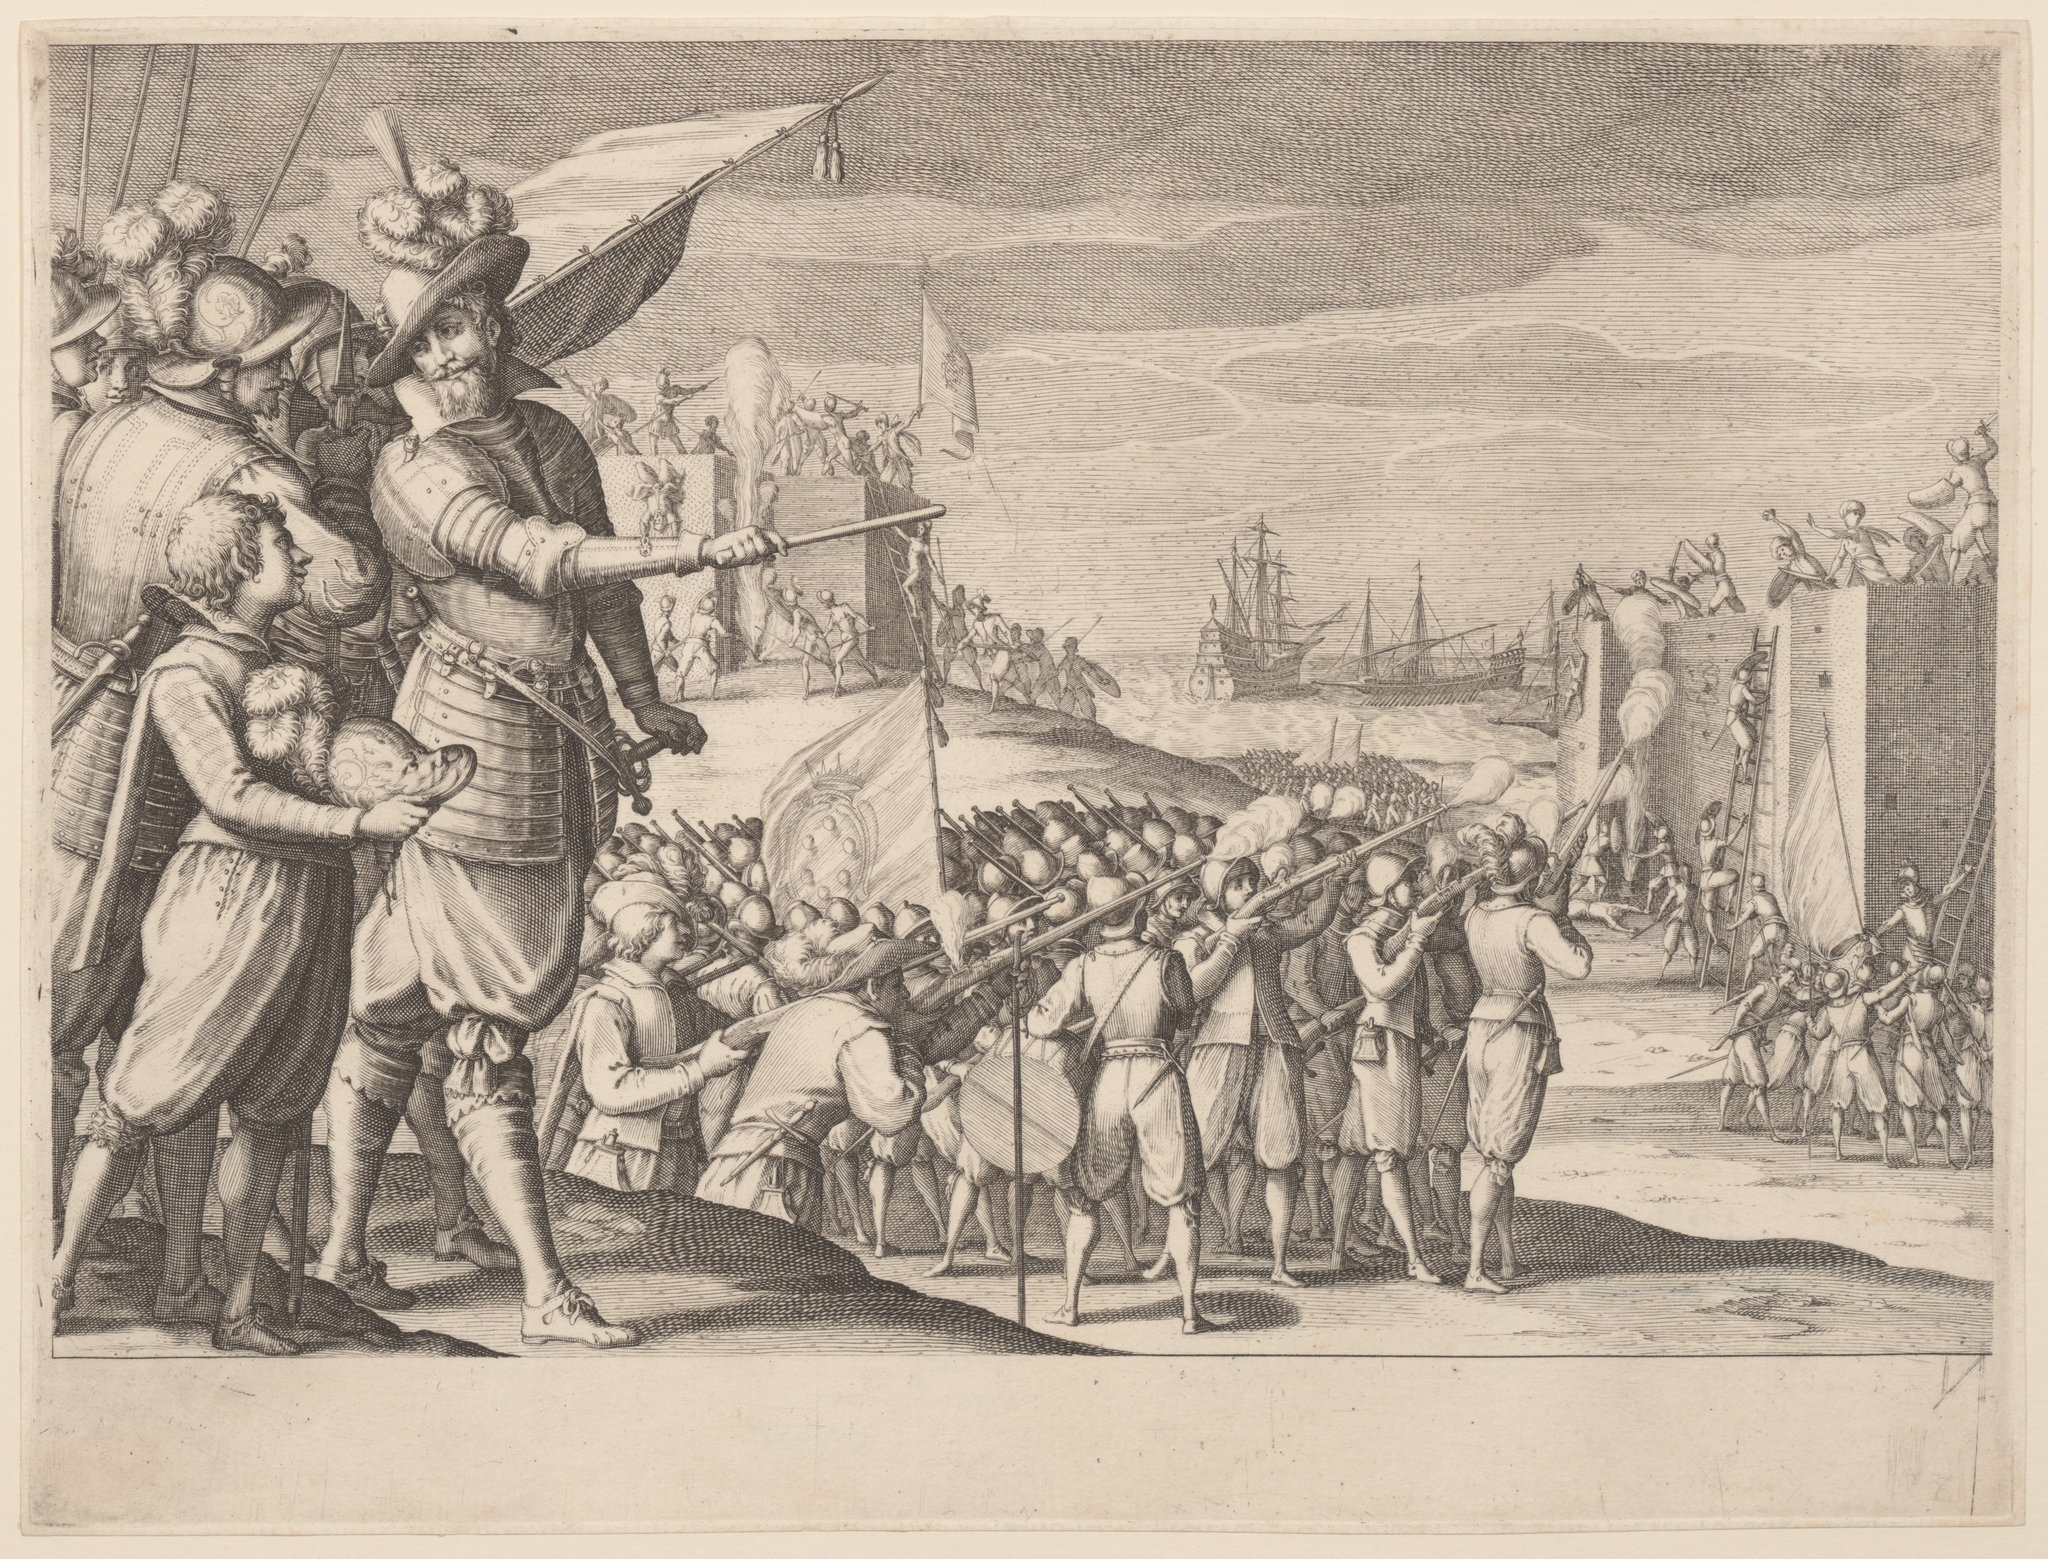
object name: print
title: Assault on two Fortresses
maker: jacques callot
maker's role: artist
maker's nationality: french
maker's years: 1592-1635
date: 1601-1633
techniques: etching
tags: fortification,soldiers,weapons,flags,ships